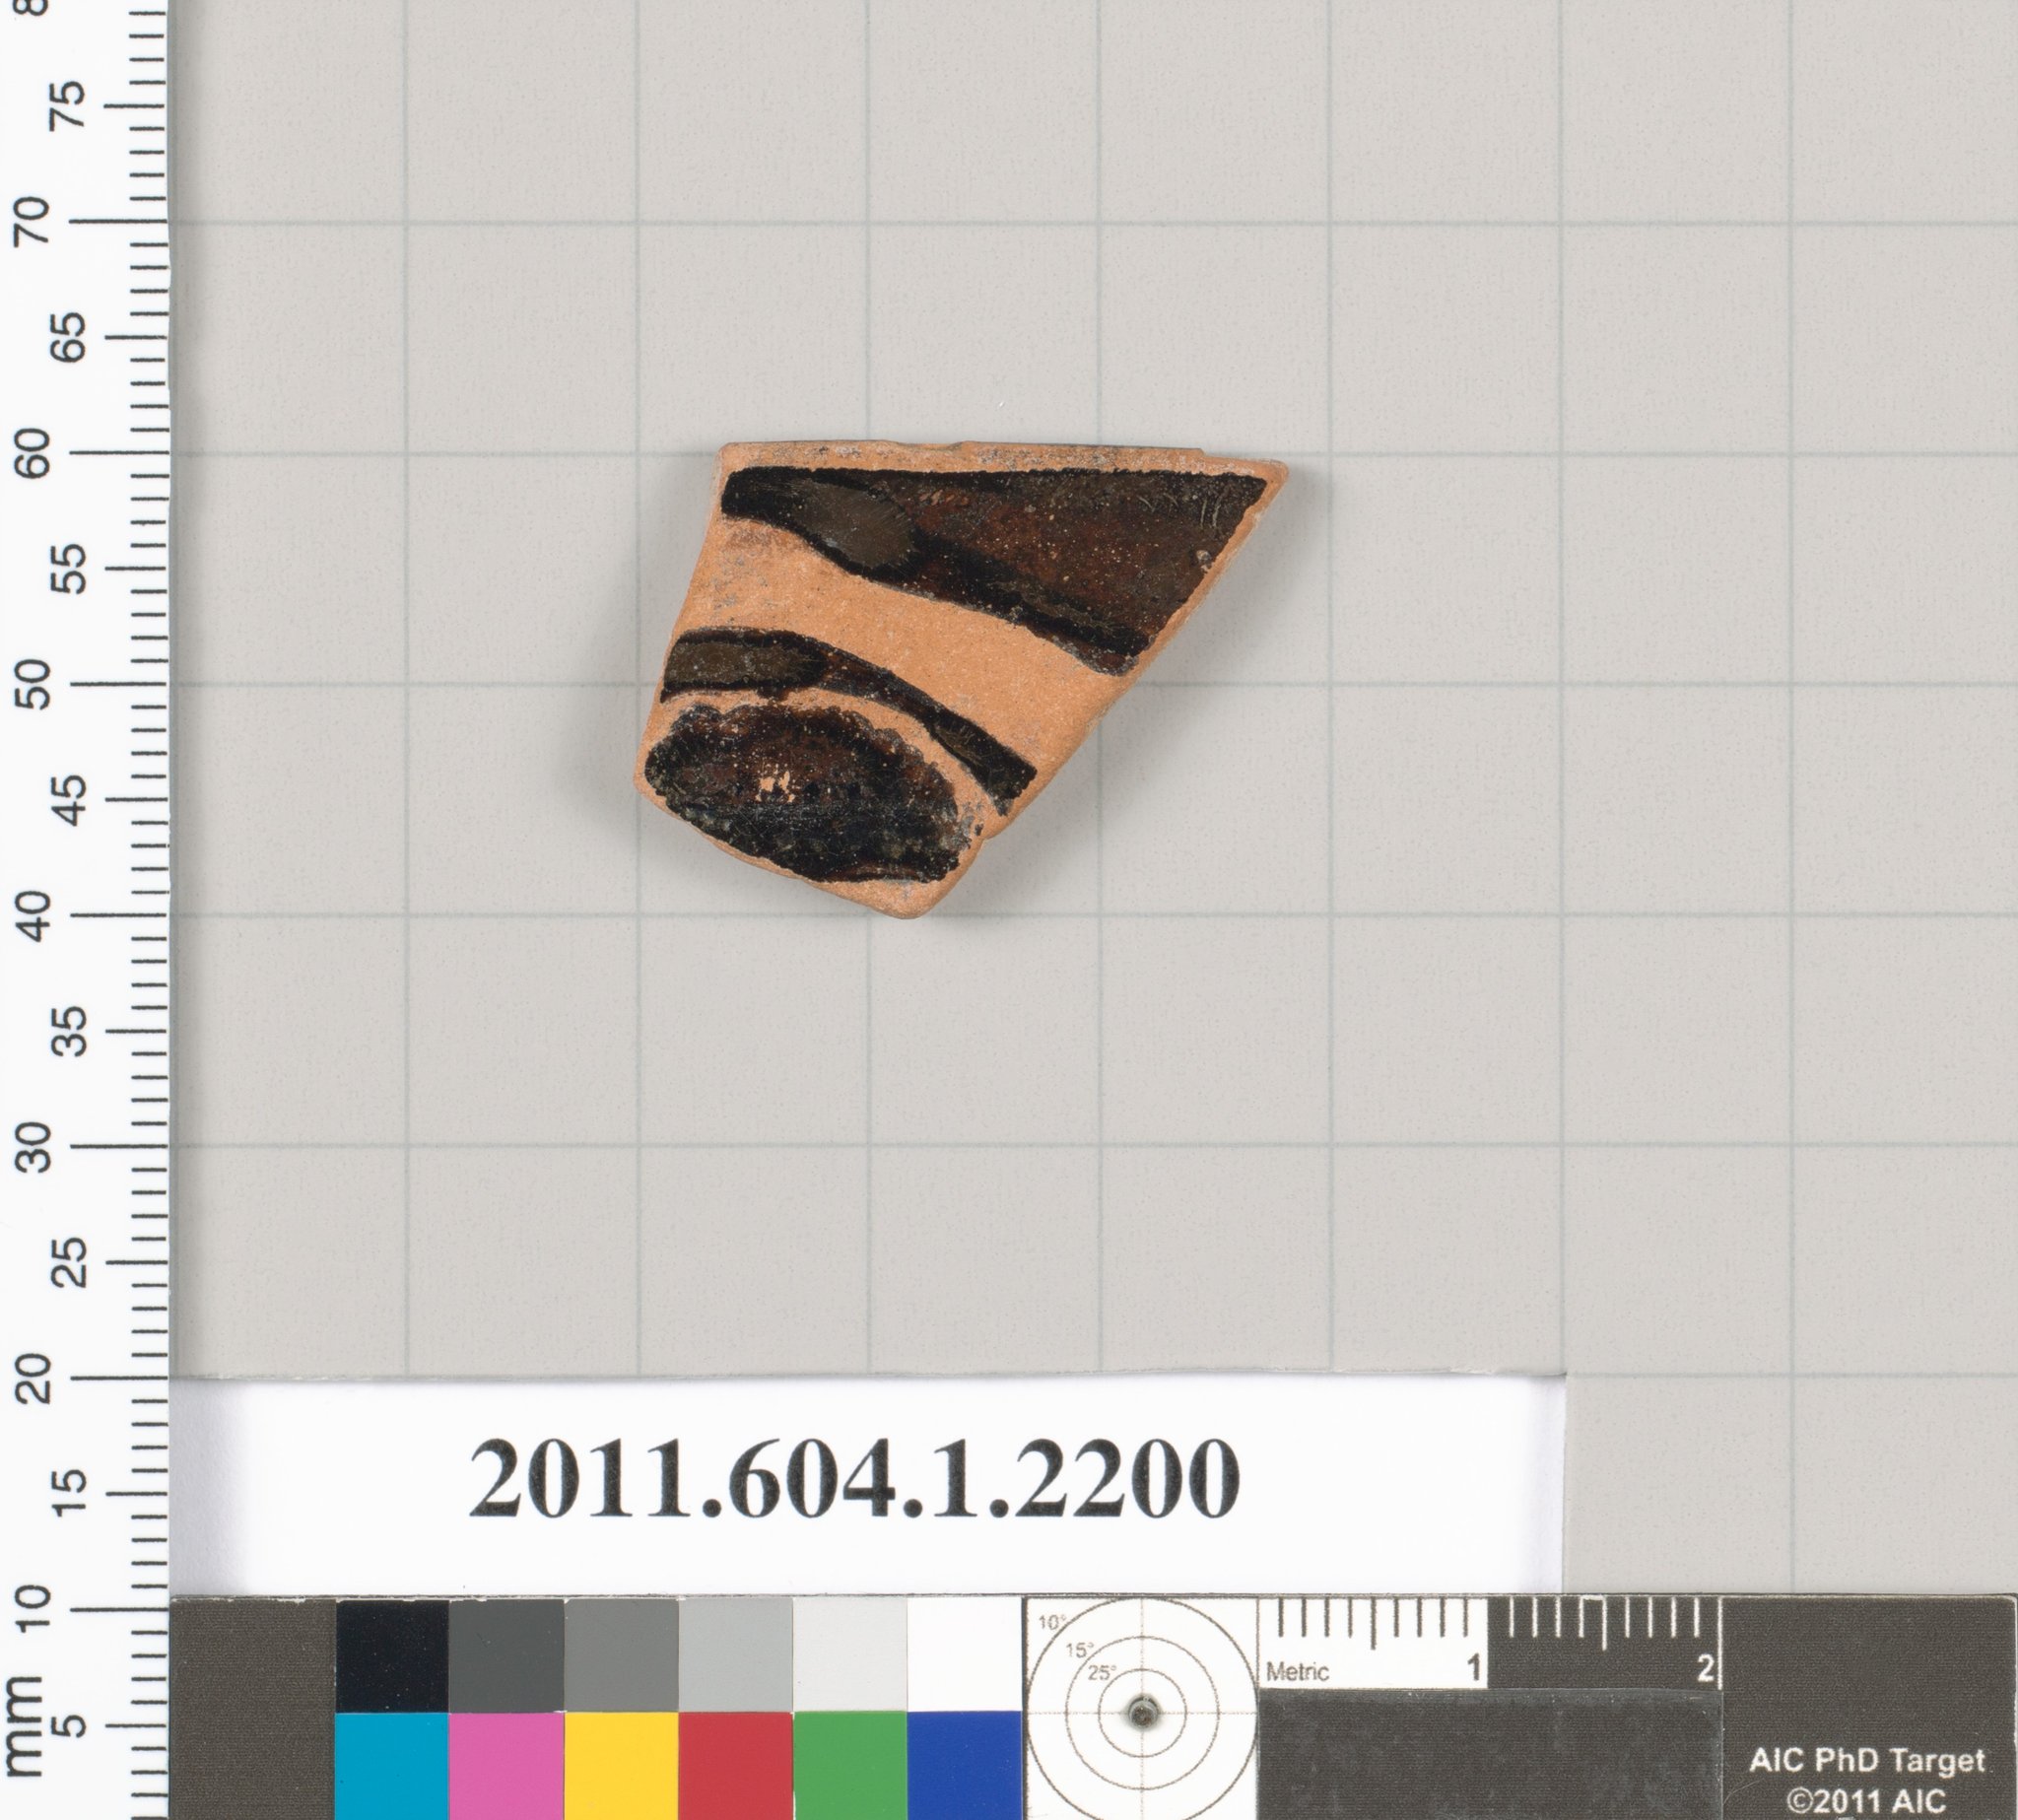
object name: kylix fragment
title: Terracotta rim fragment of a kylix (drinking cup)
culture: greek, attic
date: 475-451 BCE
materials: terracotta